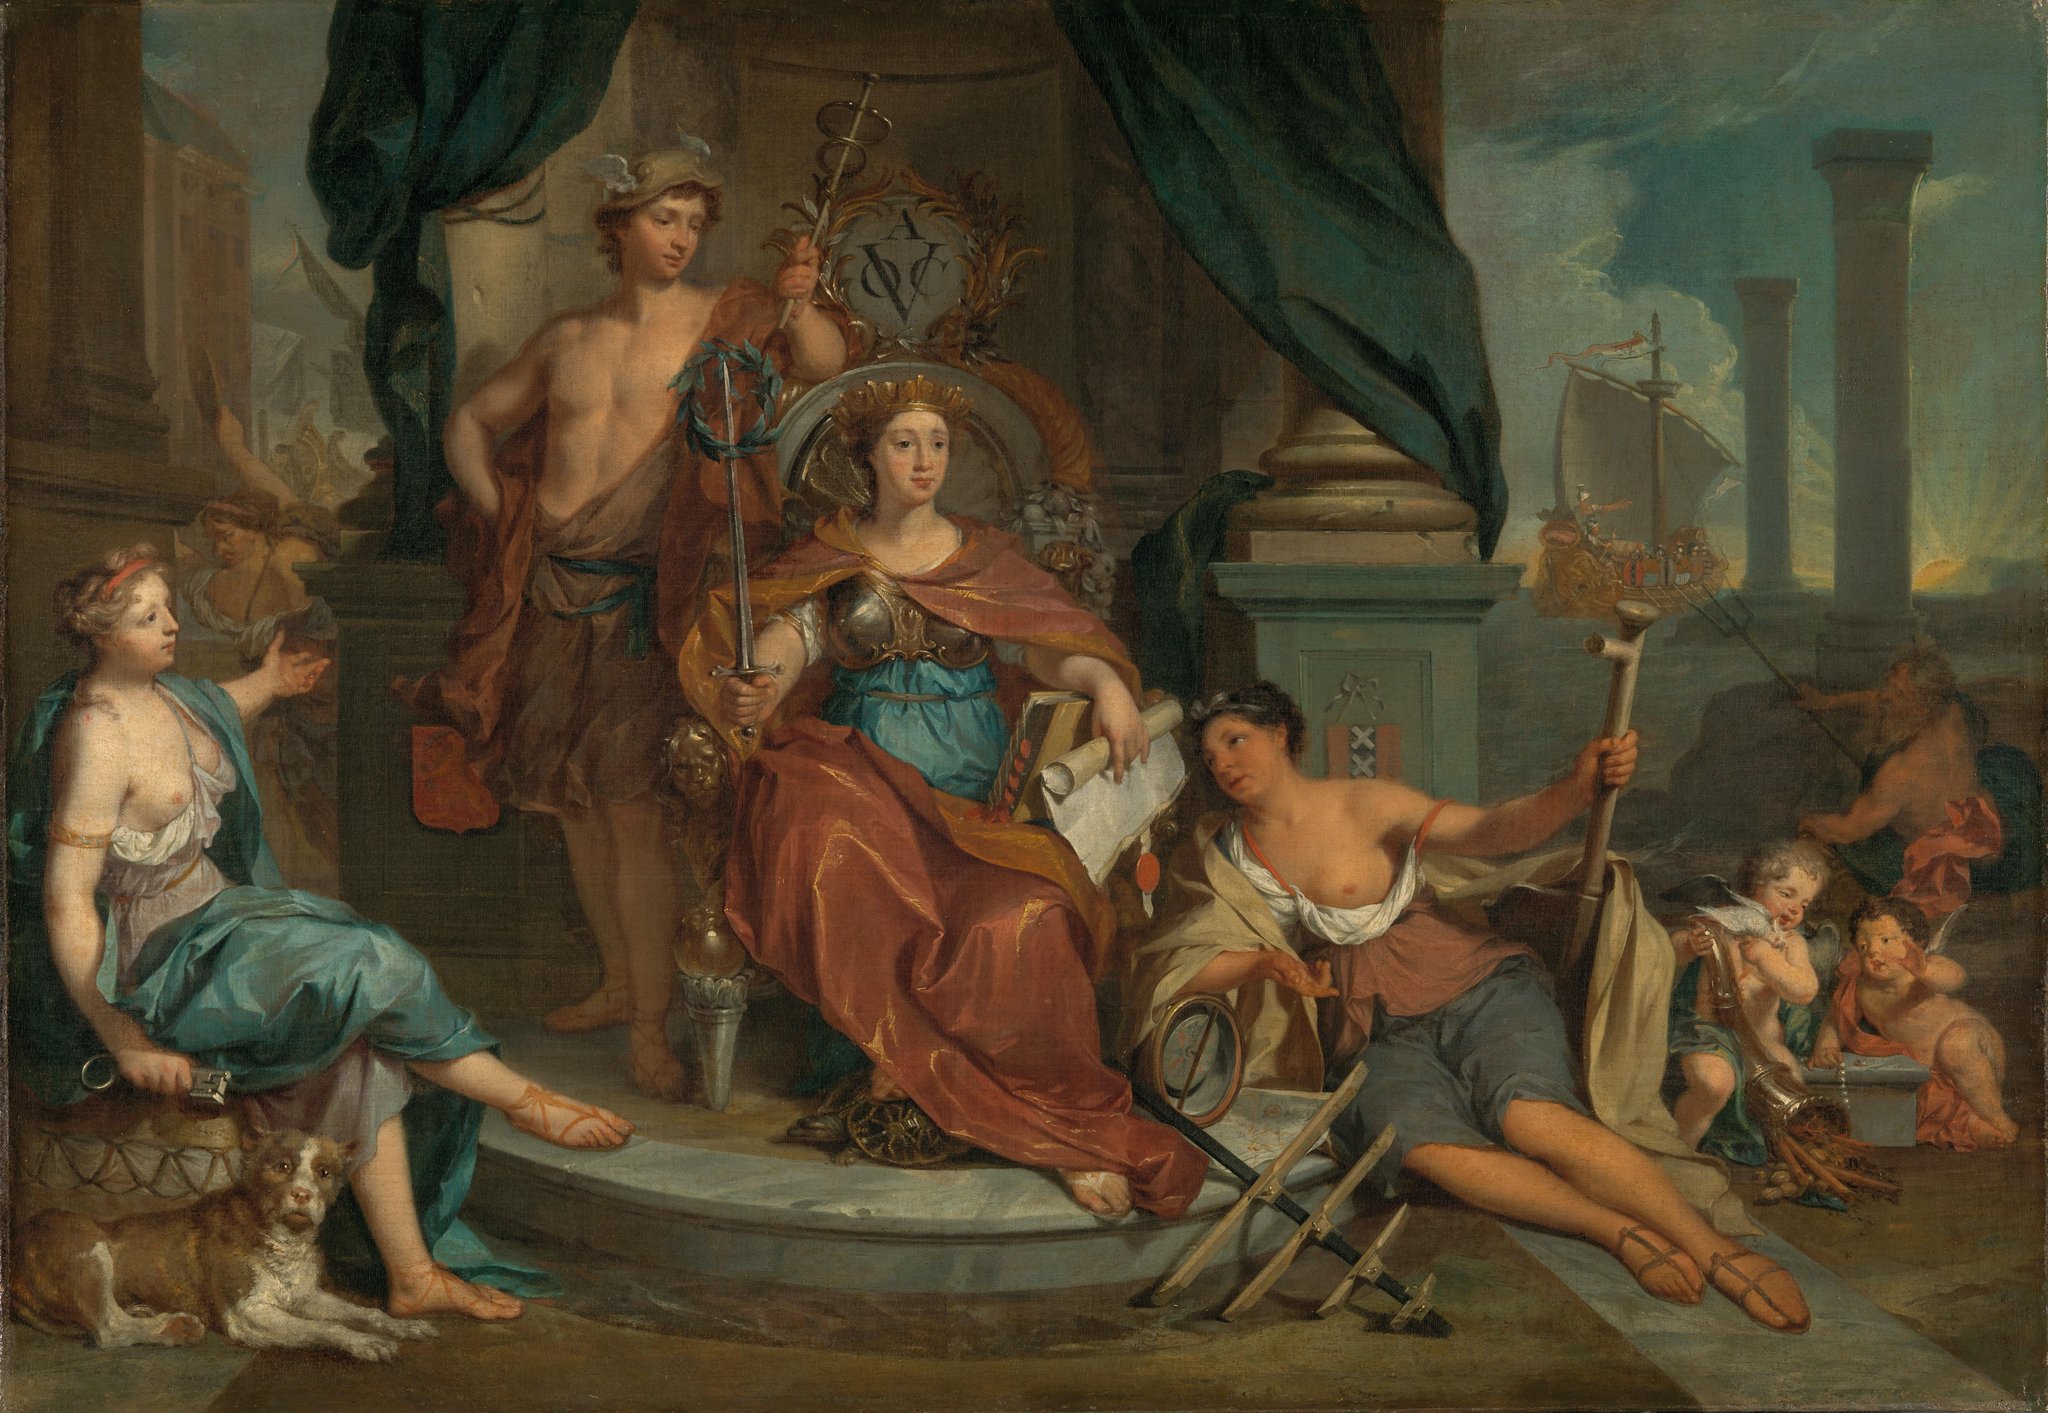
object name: painting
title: Apotheosis of the Dutch East India Company (Allegory of the Amsterdam Chamber of Commerce of the VOC)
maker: nicolaas verkolje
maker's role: draughtsman, painter, print maker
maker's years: 1673-1746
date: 1702-1746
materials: canvas, oil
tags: amsterdam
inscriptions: signature: ‘N. Verkolje fecit’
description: Allegorische voorstelling met de vrouwelijke personificatie van de Amsterdamse Kamer van de Verenigde Oost-Indische Compagnie gezeten op een troon. Op het hoofd draagt zij een schepenkroon, in de rechterhand een zwaard met lauwerkrans, in de linkerhand boeken en documenten. Achter de troon Mercurius, links een zittende vrouw met een hond en een sleutel, rechts een vrouwelijke personificatie met een roer in de handen. Rechts twee putti, Neptunus en een galei bij twee zuilen. Vervaardigd naar een penning uit 1702 geslagen ter ere van het eeuwfeest van de VOC.